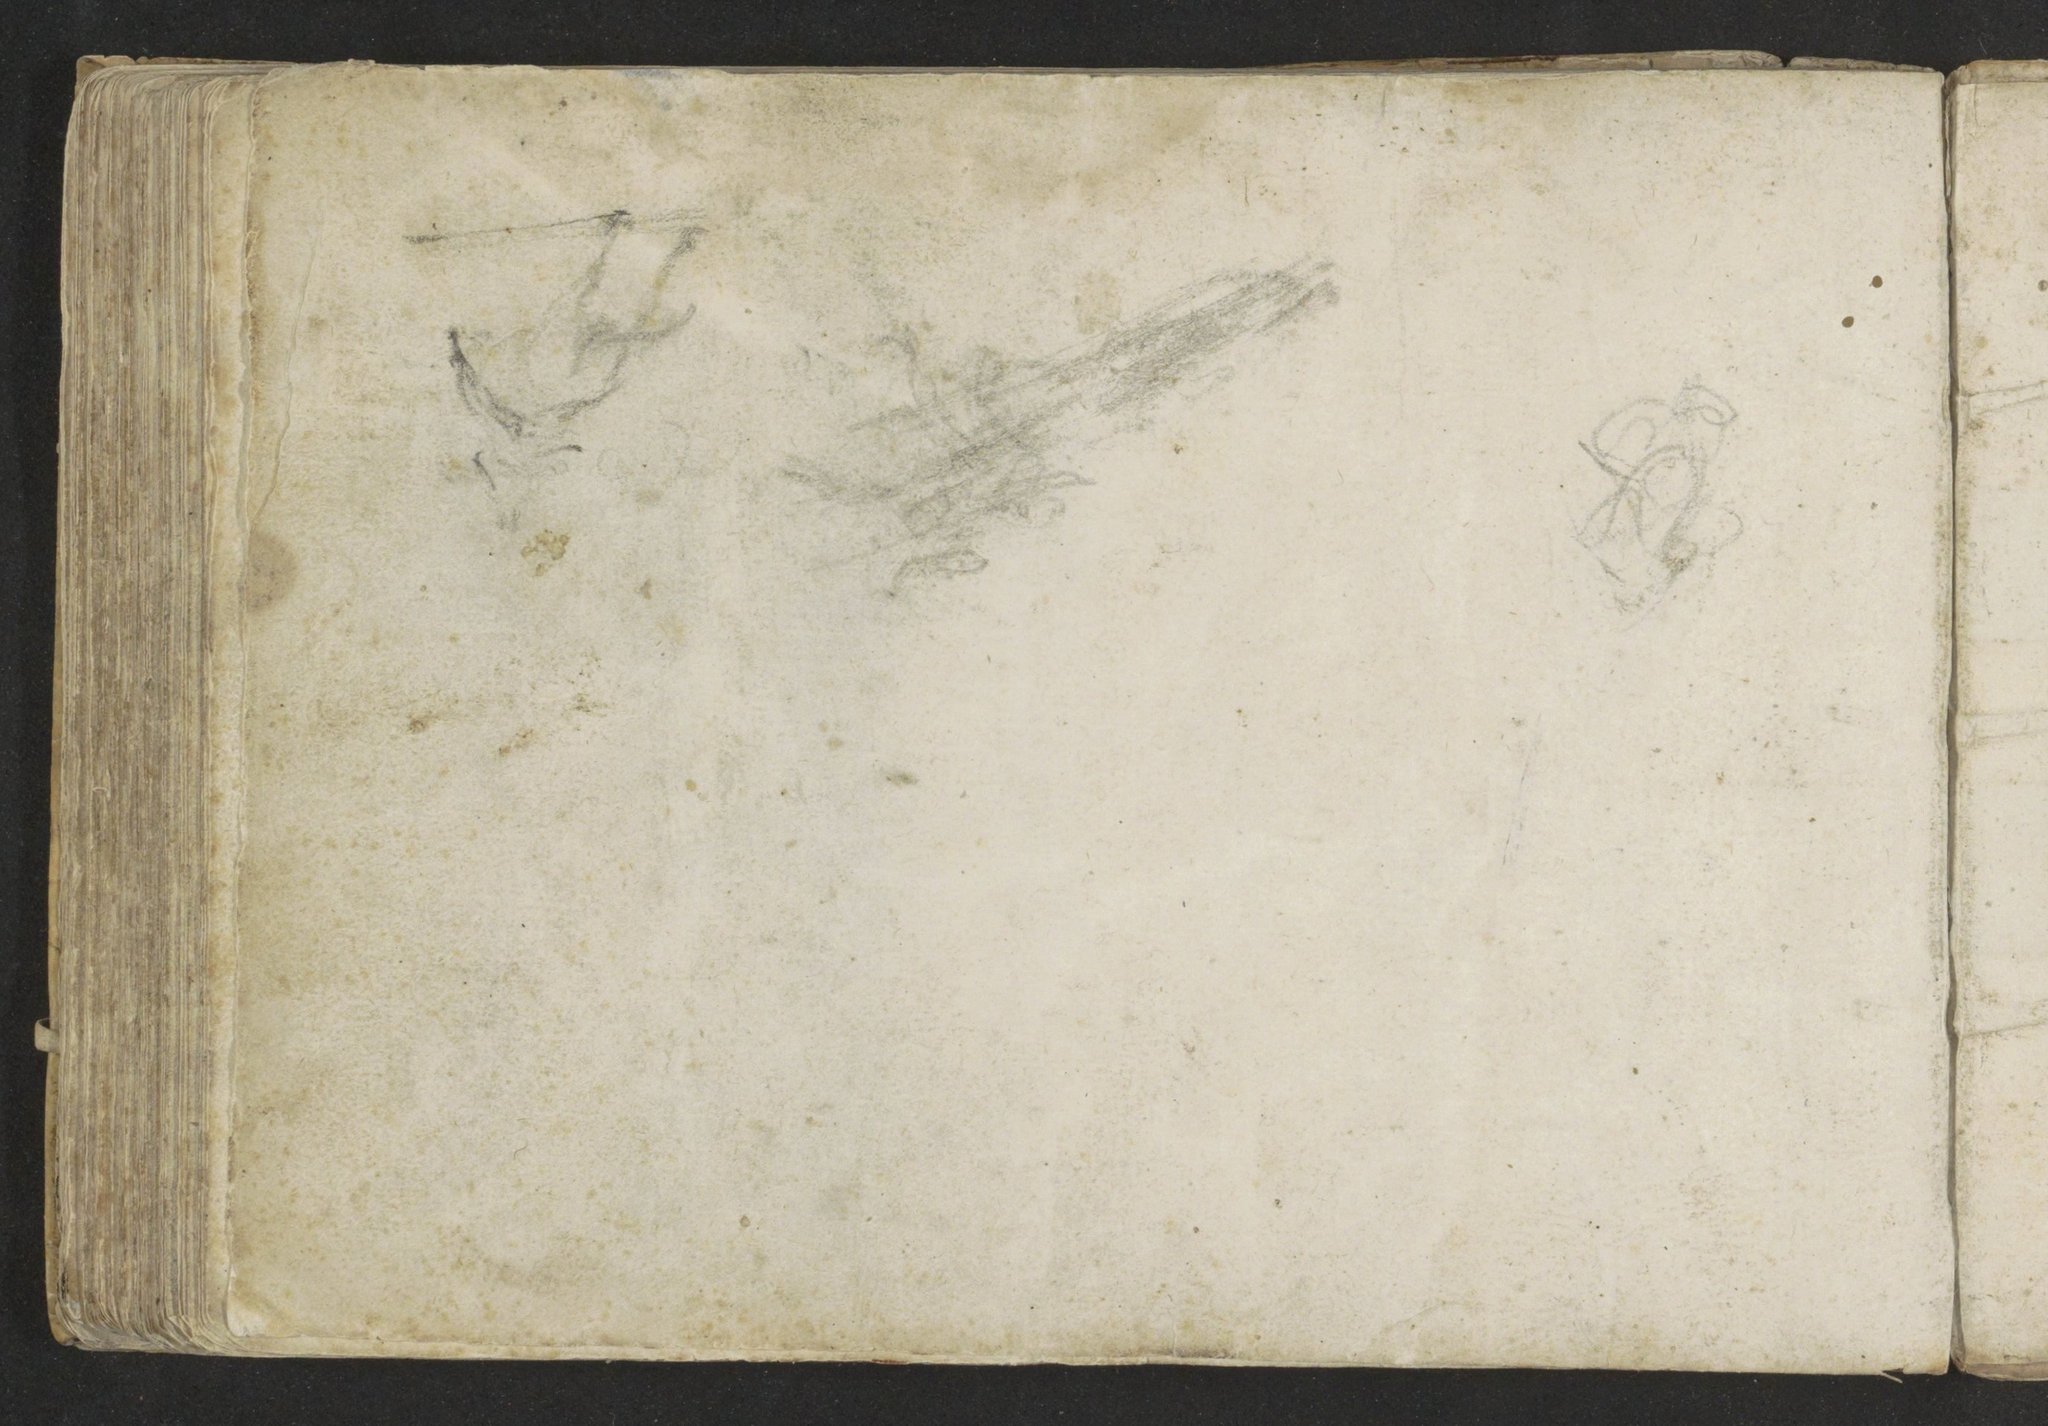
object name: sketchbook leaf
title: Galopperende ruiters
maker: gerard ter borch (ii)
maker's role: draughtsman, painter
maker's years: 1617-1681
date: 1631-1635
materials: chalk, paper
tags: riding a horse, ass, or mule; rider, horseman, galloping horse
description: De twee schetsen zijn waarschijnlijk door een van de Ter Borch kinderen toegevoegd aan het schetsboek.